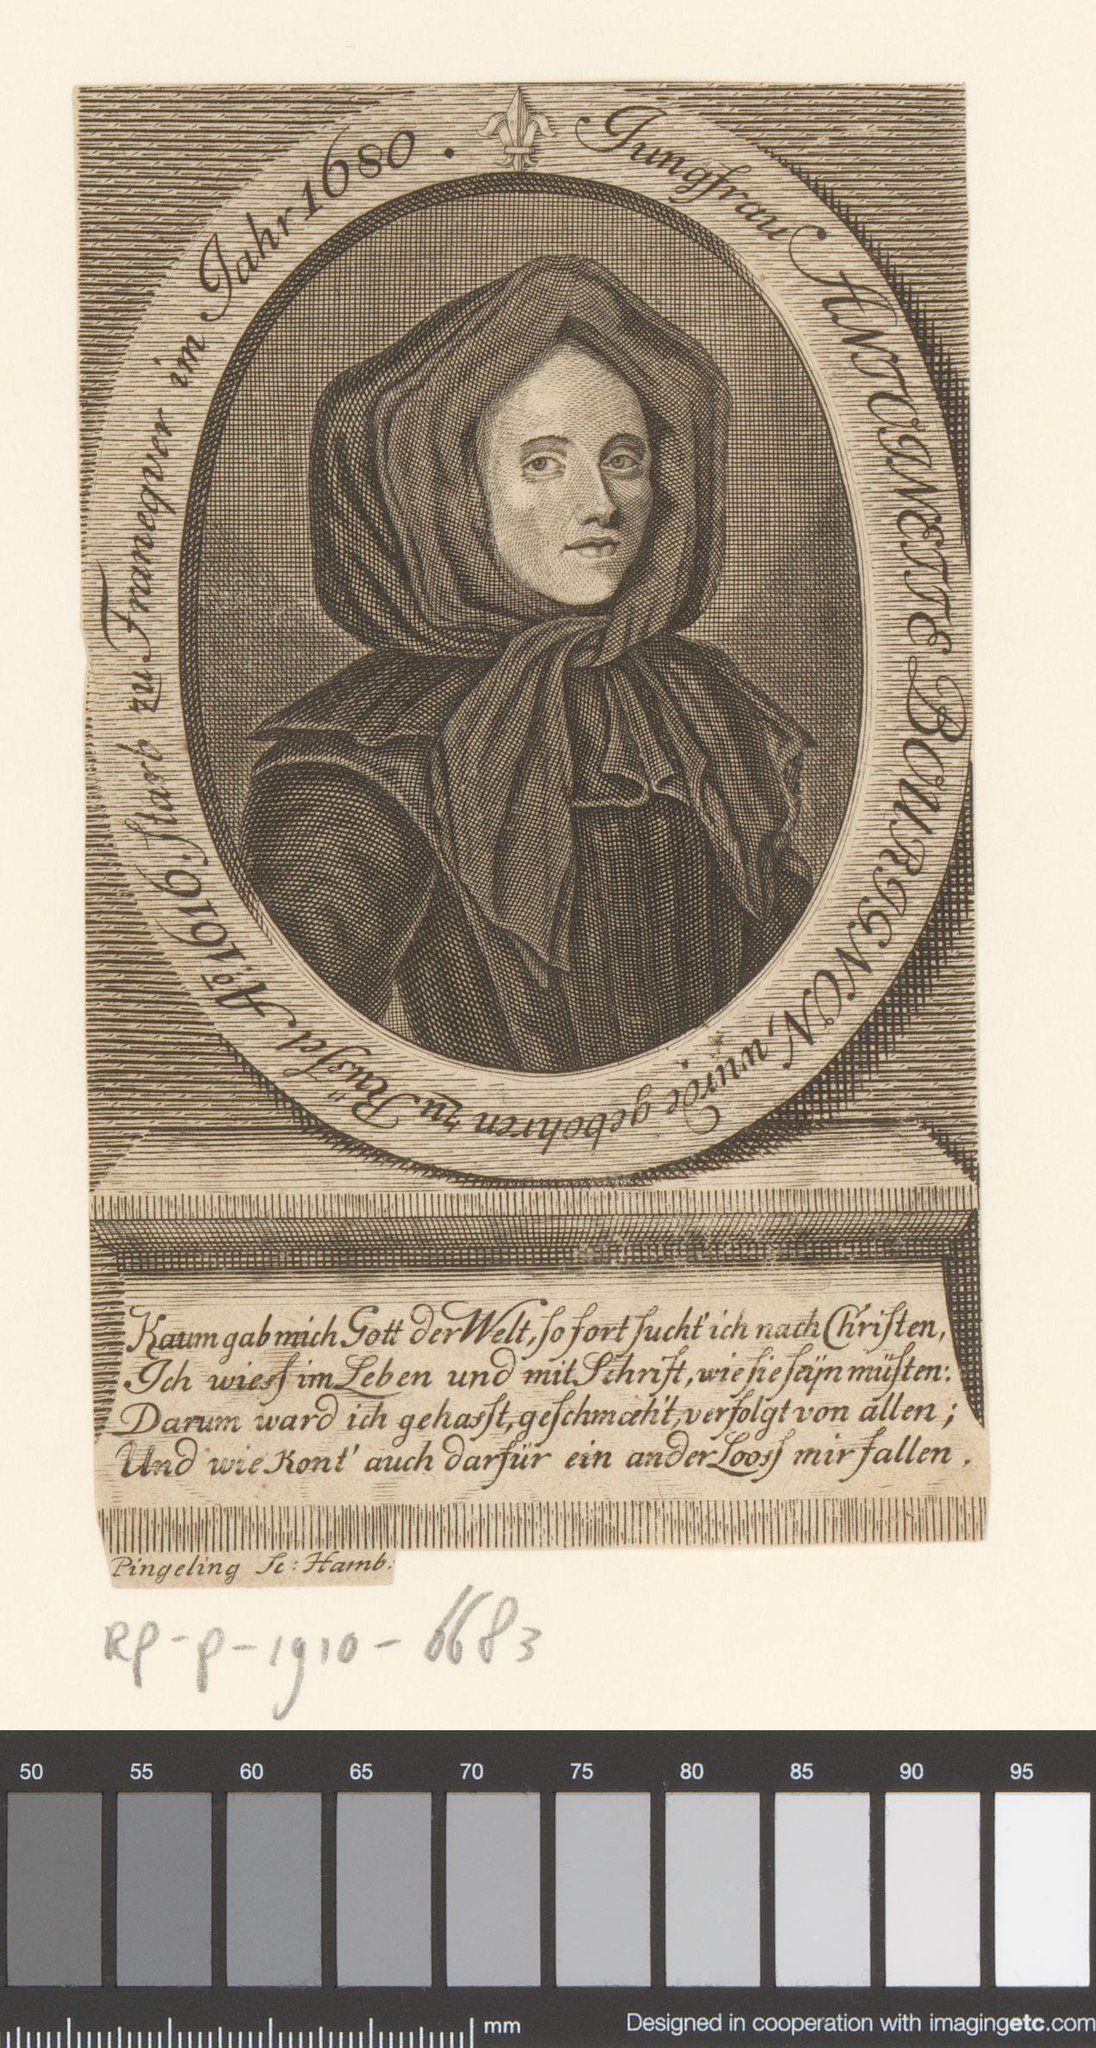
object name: print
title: Portret van Antoinette Bourignon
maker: gottfried christian pingeling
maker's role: print maker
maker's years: 1688-1769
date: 1698-1769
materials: paper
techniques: engraving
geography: hamburg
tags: lille, historical persons - bb - woman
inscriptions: collector's mark: Lugt 2228